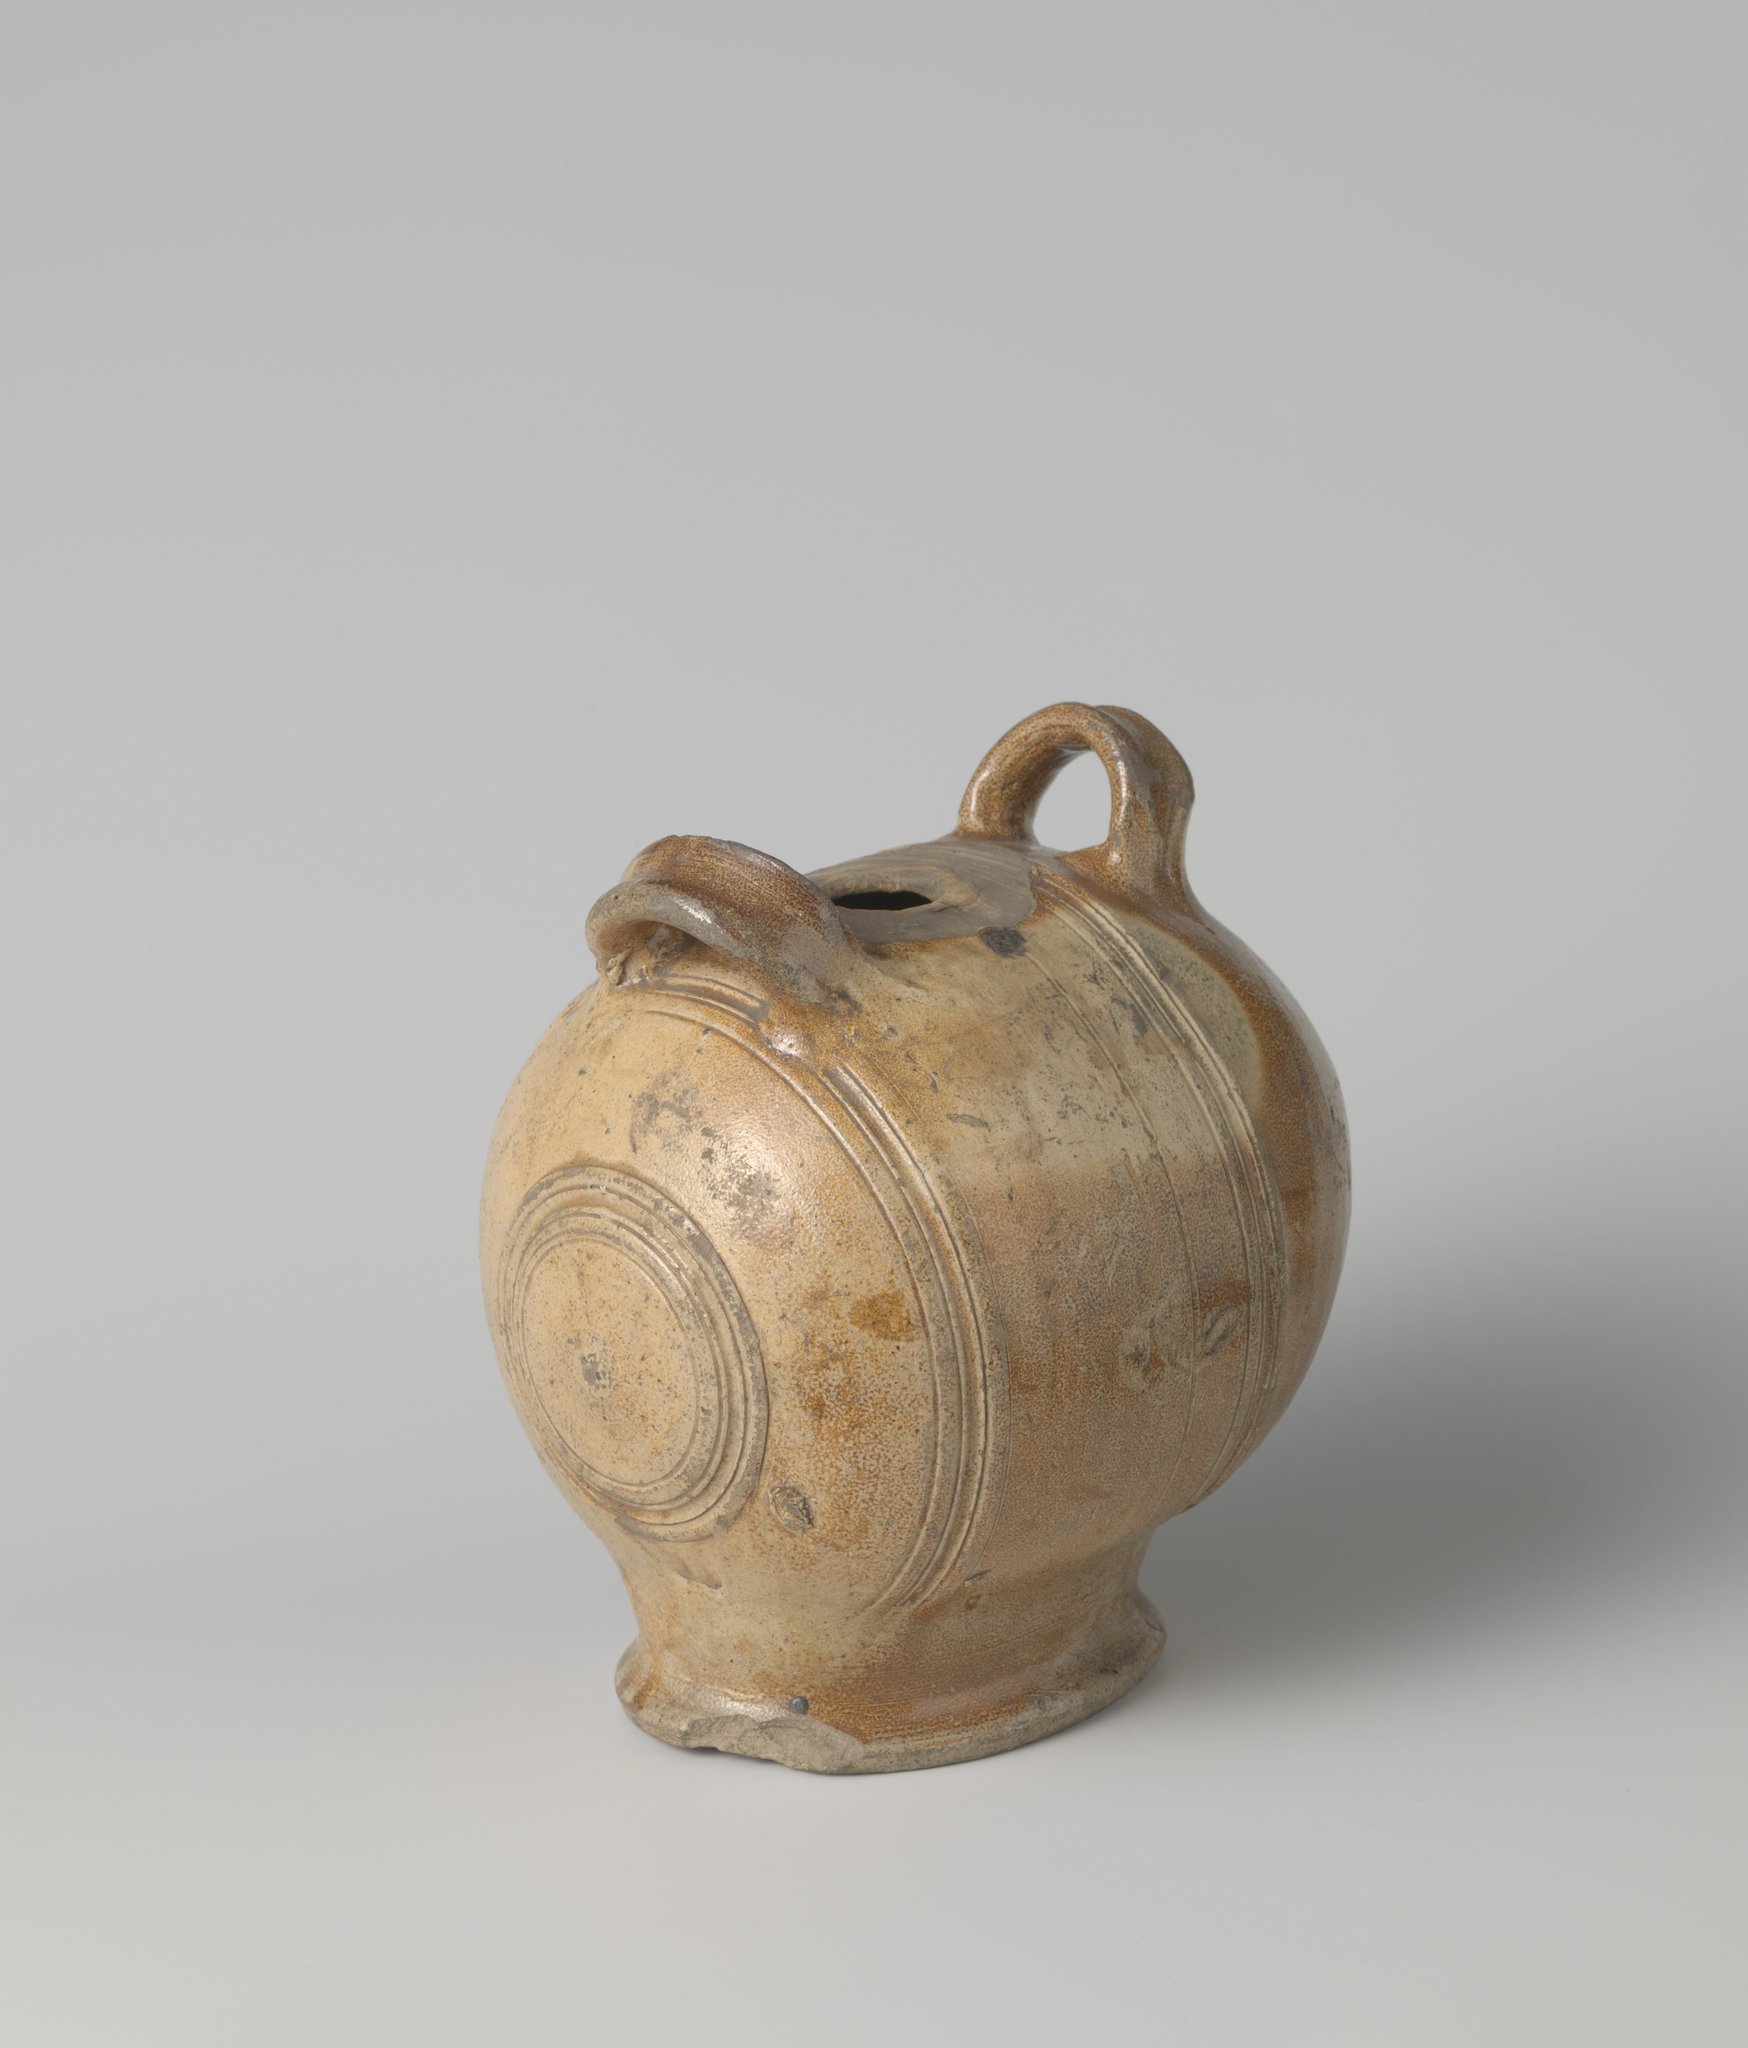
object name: vessel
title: Cask with two handles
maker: Anonymous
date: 1600-1699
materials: engobe, glaze, stoneware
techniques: firing, forming, relief, turning, vitrification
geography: bouffioulx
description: Vat of meiwijnvat van steengoed op hoge voet, in de vorm van een houten vat met twee oren naast de stop. Profielen op de buik. Bedekt met een bruine engobe. De stop ontbreekt. Bouffioulx.